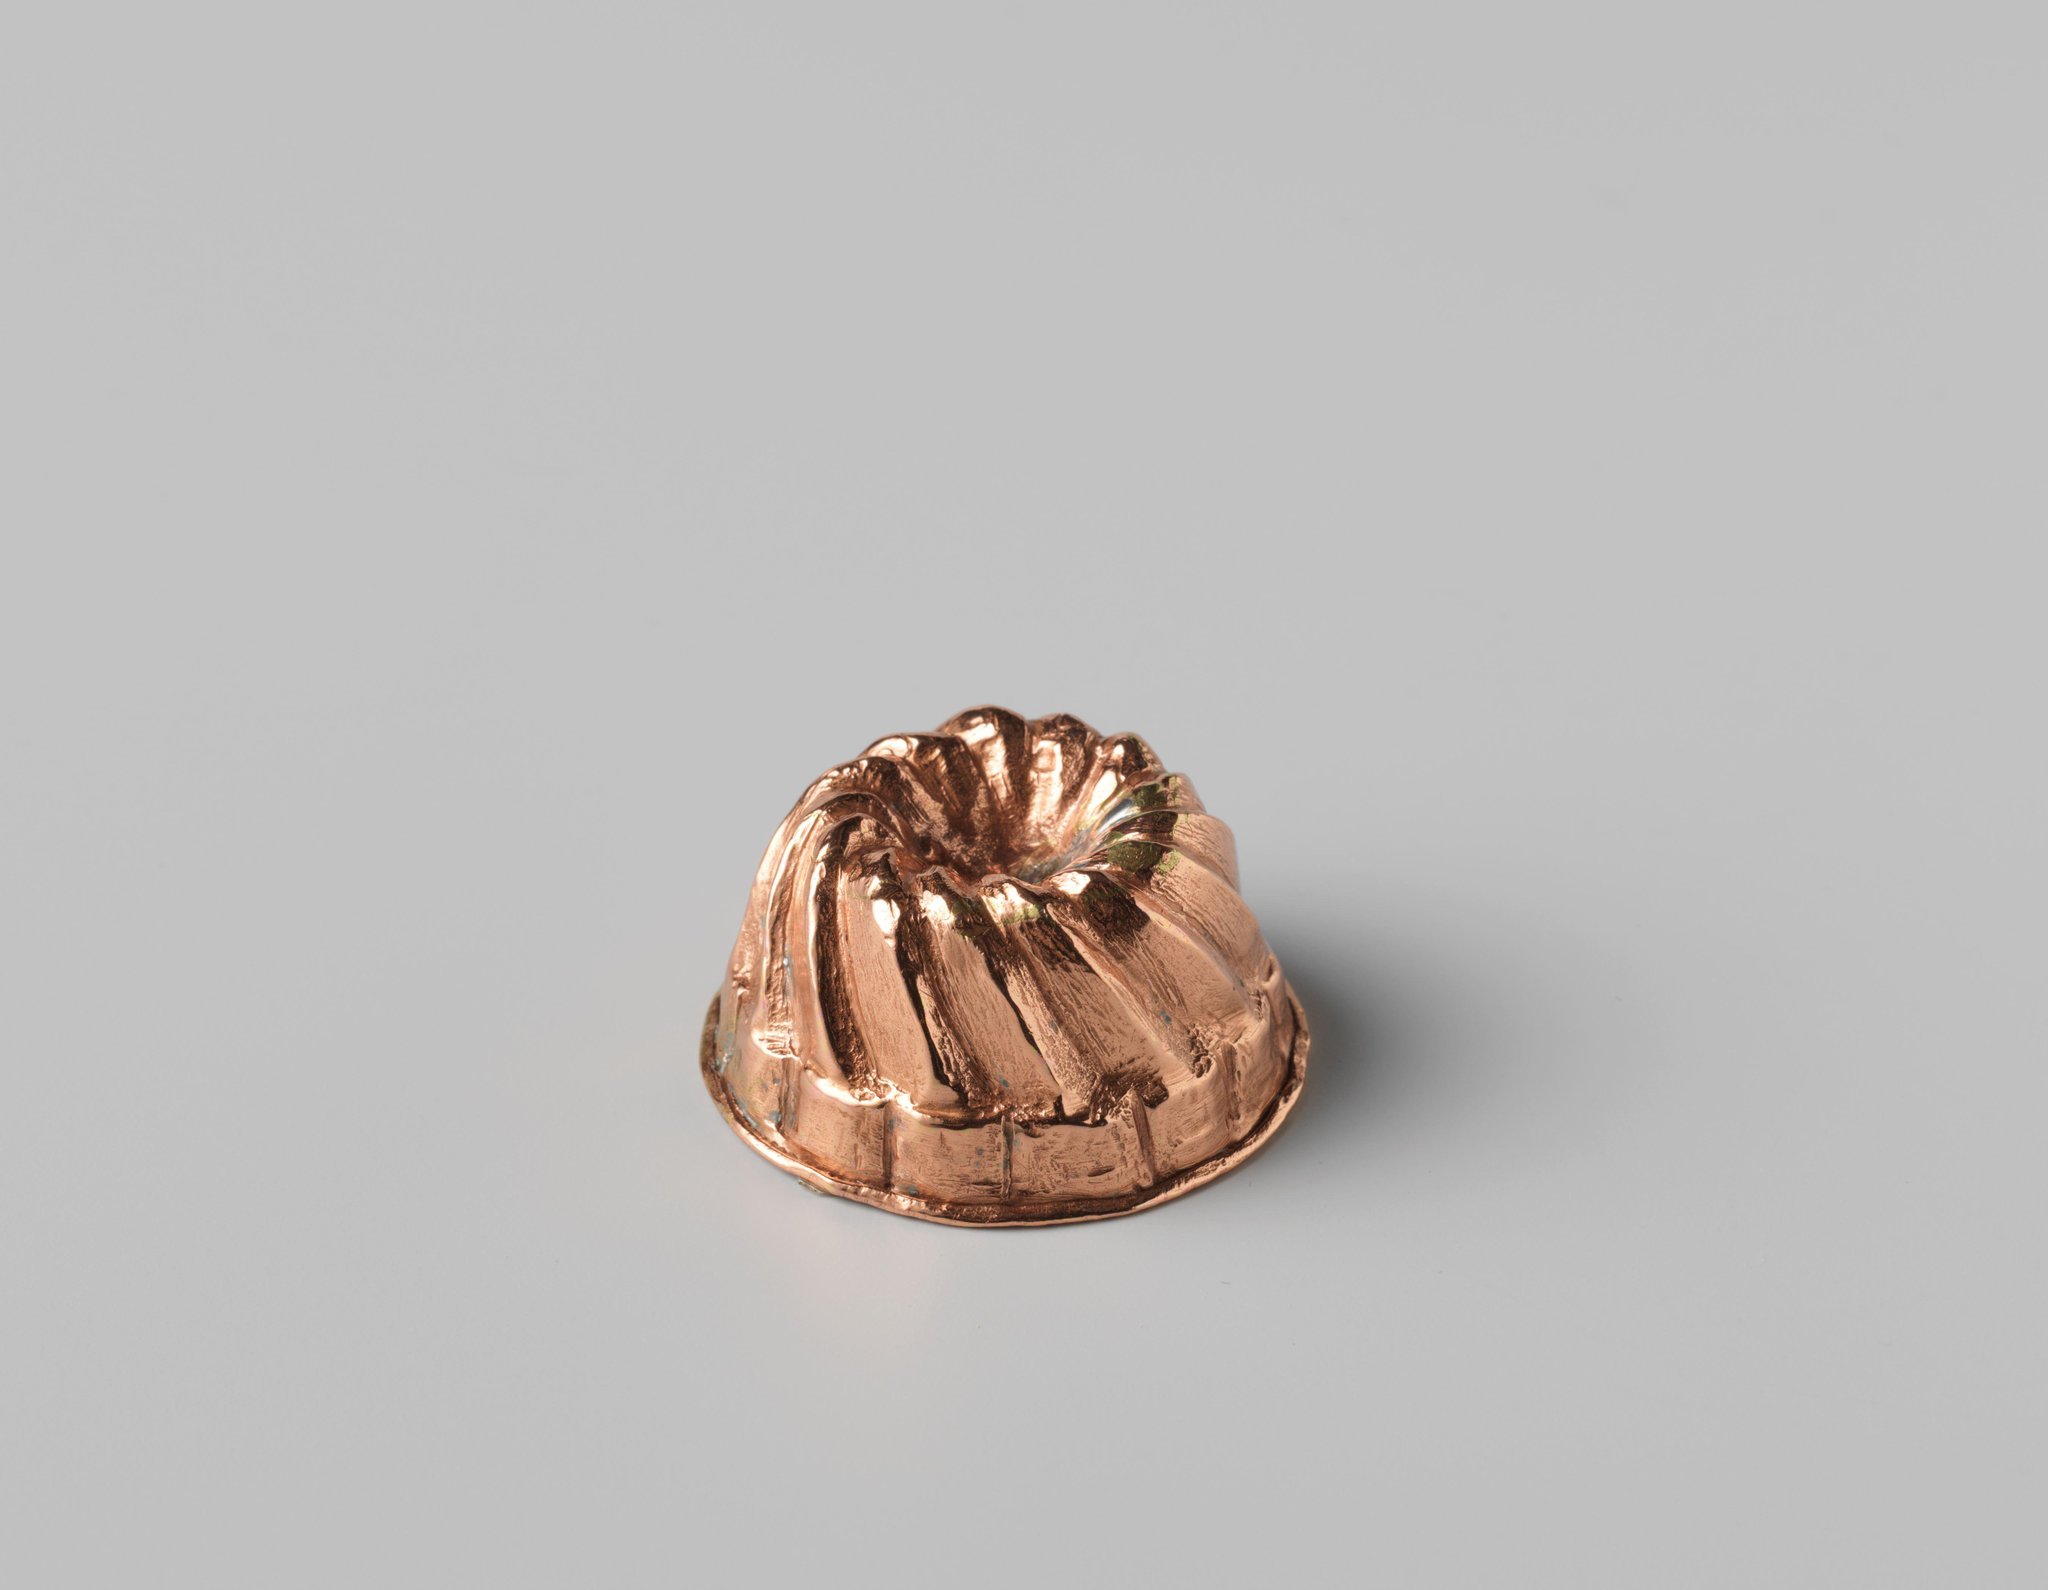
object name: tube pan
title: Tulbandvorm, spiraalvormig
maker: Anonymous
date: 1700-1799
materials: copper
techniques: tinning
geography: amsterdam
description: Tulbandvorm van roodkoper, spiraalvormig, van binnen vertind.